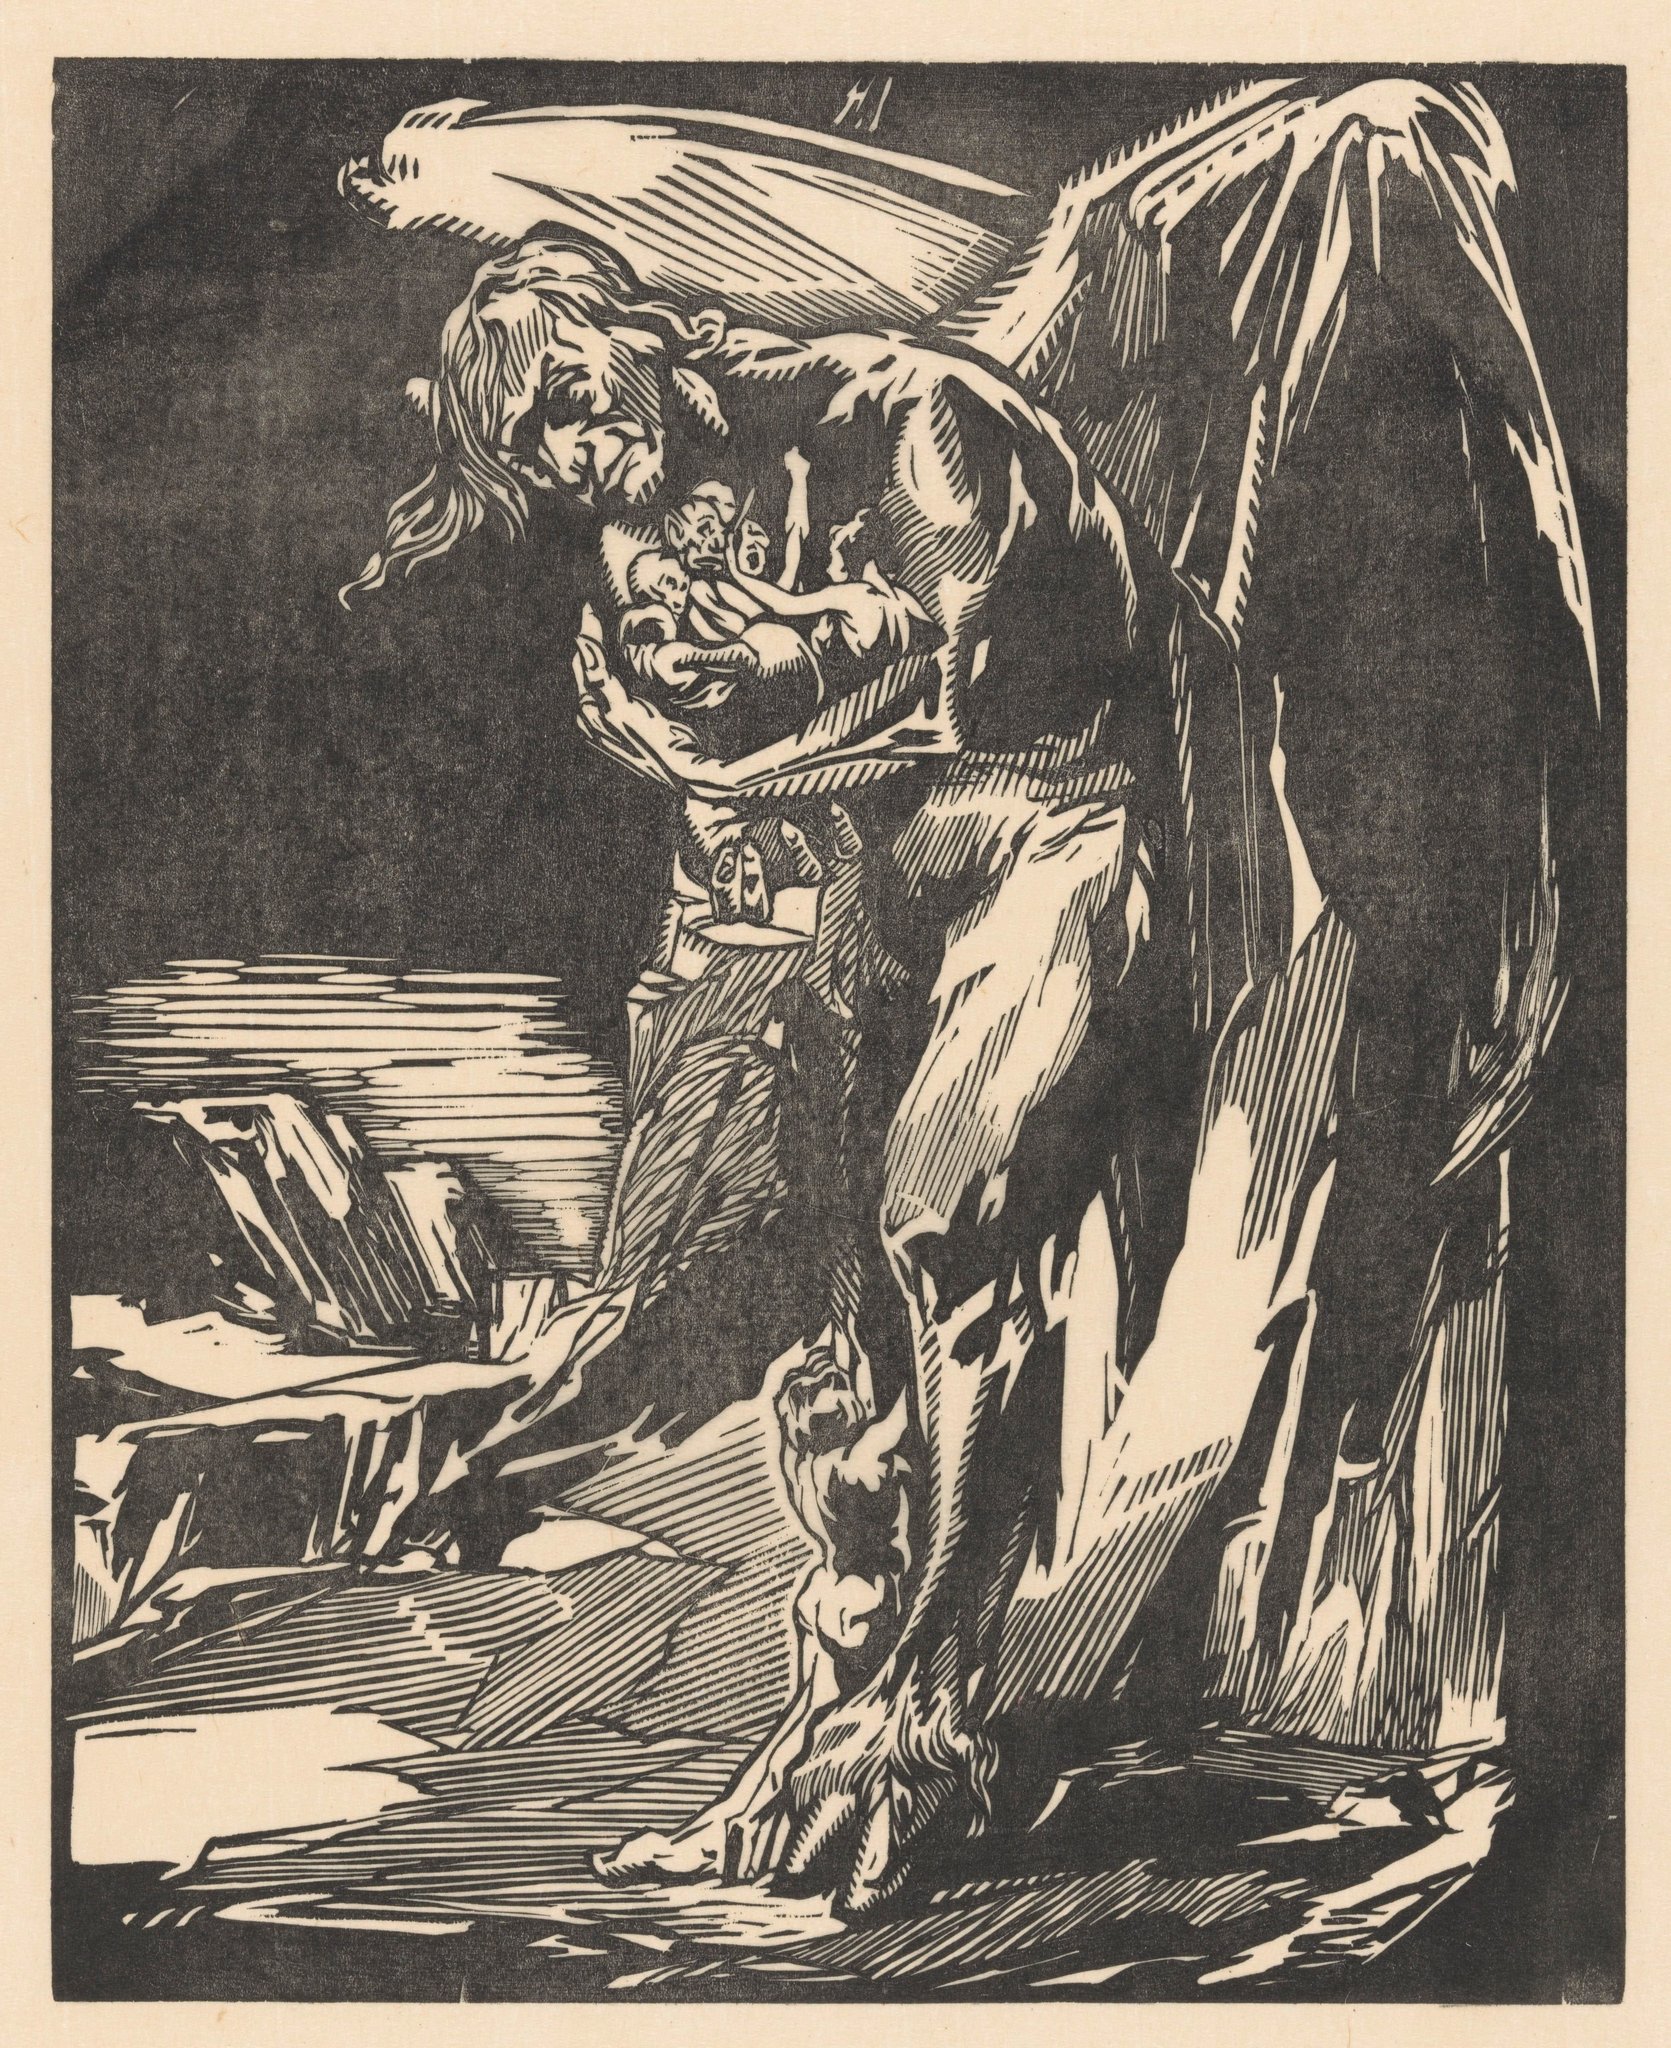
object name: print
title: Satan met figuren in zijn armen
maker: johannes josephus aarts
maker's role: draughtsman, print maker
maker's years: 1871-1934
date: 1881-1934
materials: paper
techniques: woodcut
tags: hell and purgatory, devil(s) and demons: satan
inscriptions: collector's mark: Lugt 2760, collector's mark: Lugt 2166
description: Satan, herkenbaar aan zijn vleugels en gespleten hoeven, tilt een groep figuren in zijn armen op. Een andere figuur klemt zich om zijn rechterbeen heen. Het landschap is kaal en rotsachtig.